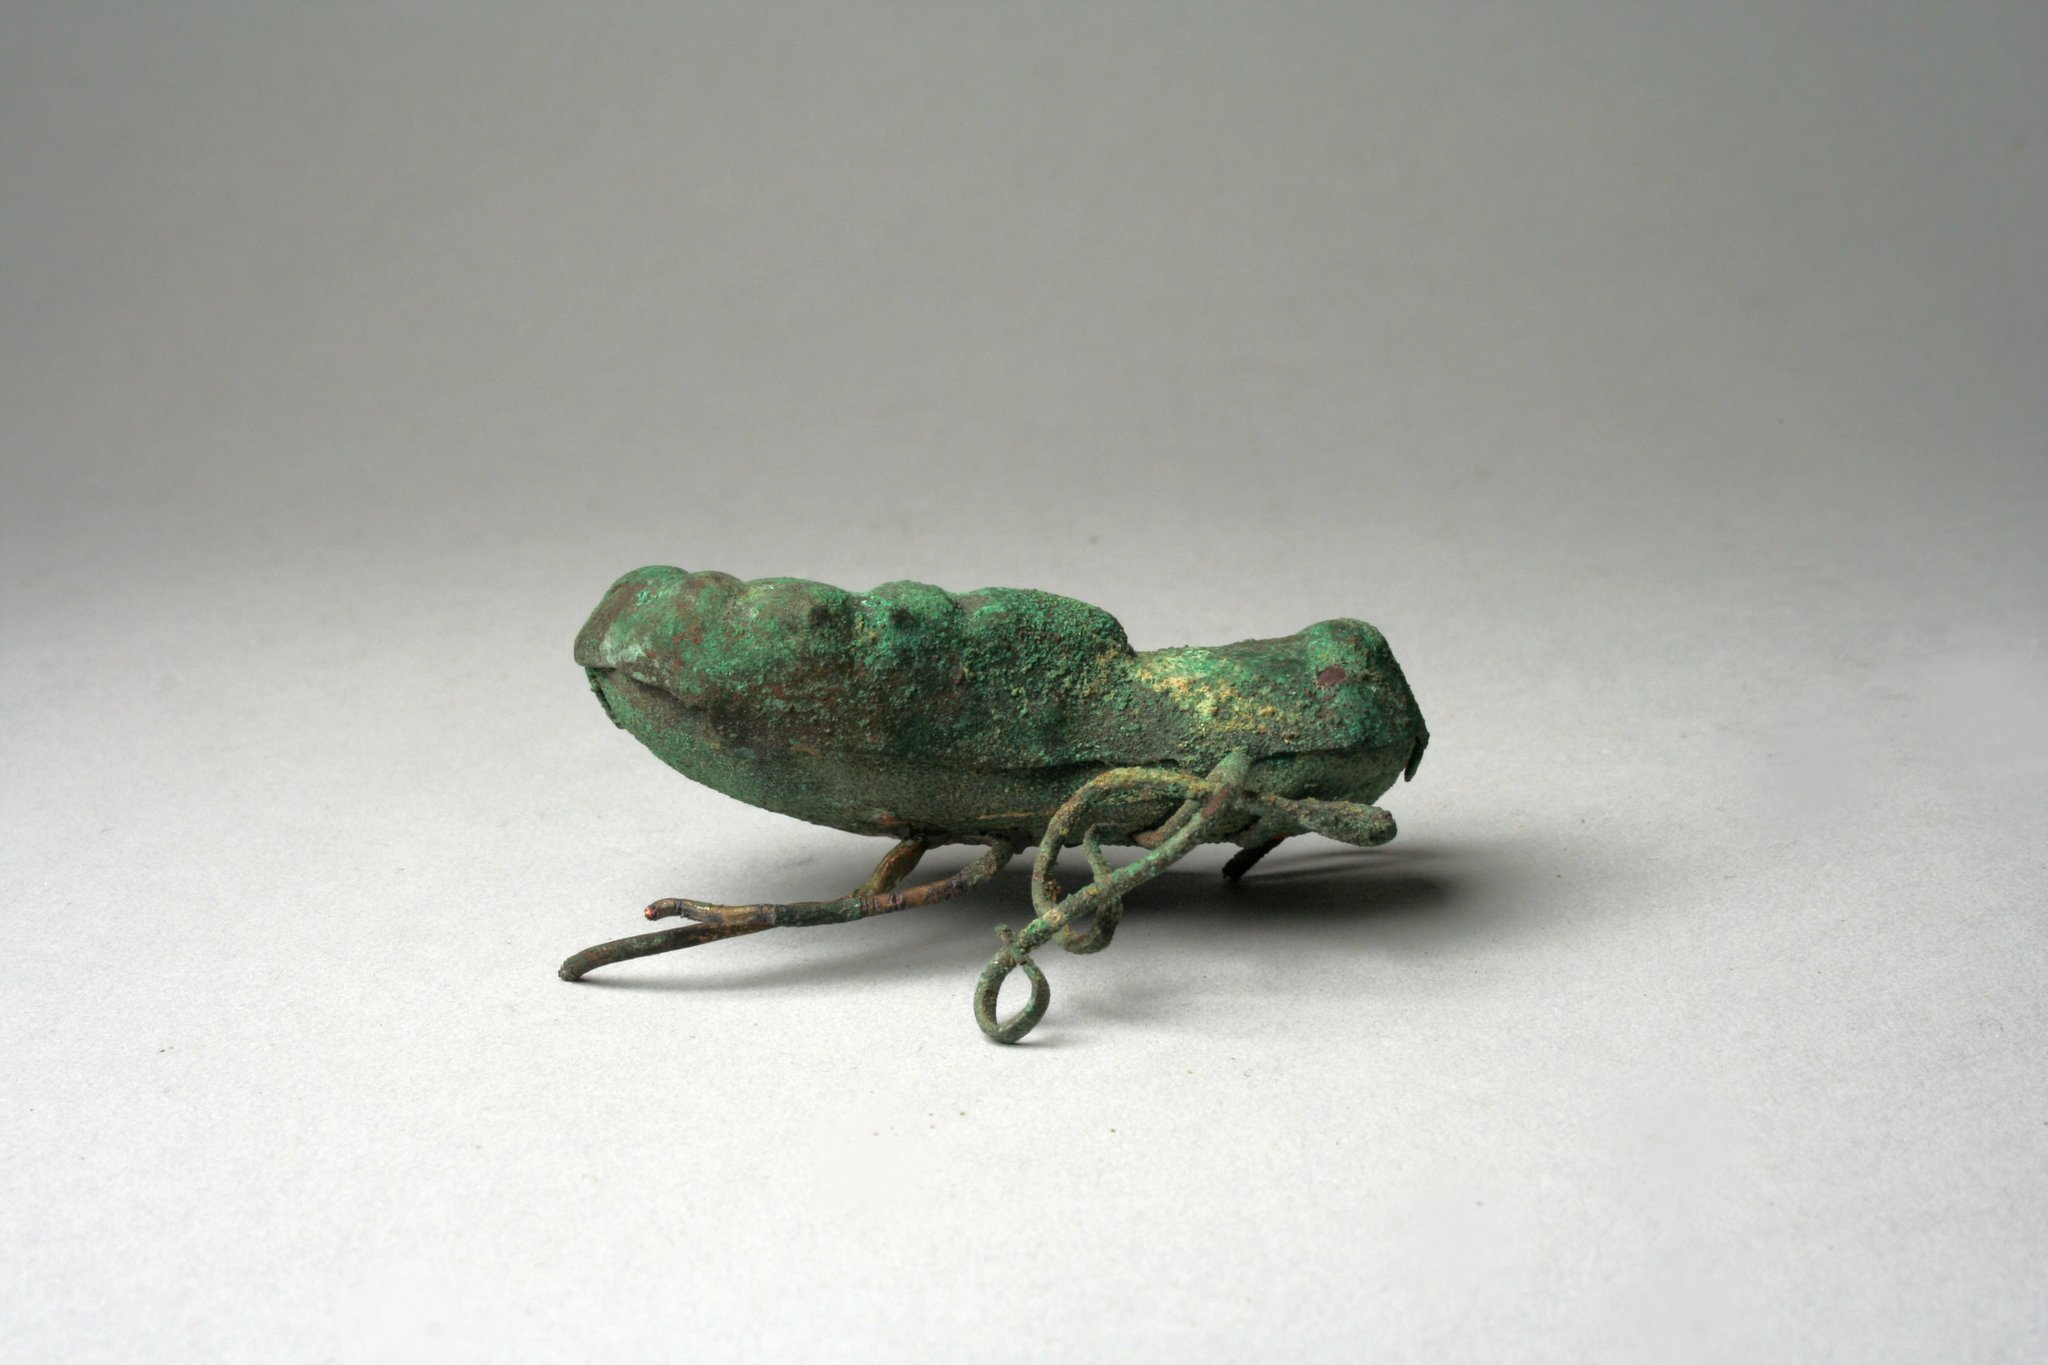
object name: ornament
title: Spider Ornament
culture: moche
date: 501-700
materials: metal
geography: peru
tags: insects